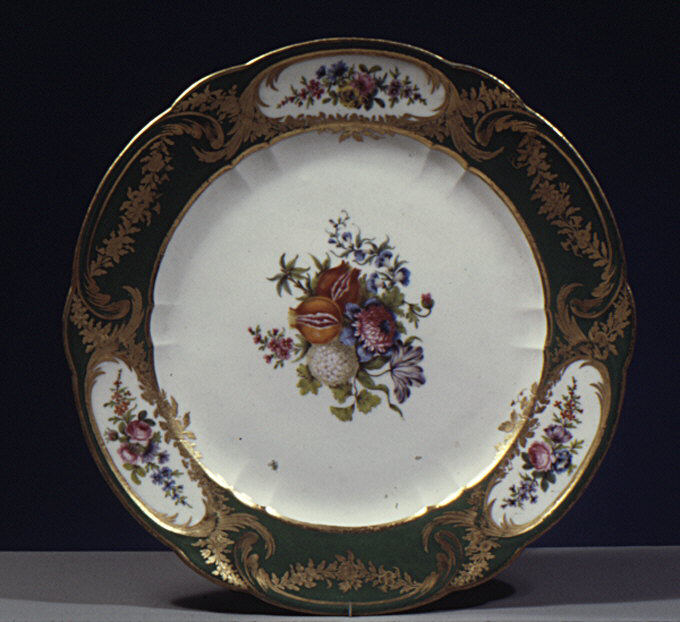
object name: plate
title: Plate (assiette à palmes) (1 of 102) (part of a service)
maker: sèvres manufactory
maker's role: manufactory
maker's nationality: french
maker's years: 1740-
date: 1786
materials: soft paste porcelain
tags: flowers